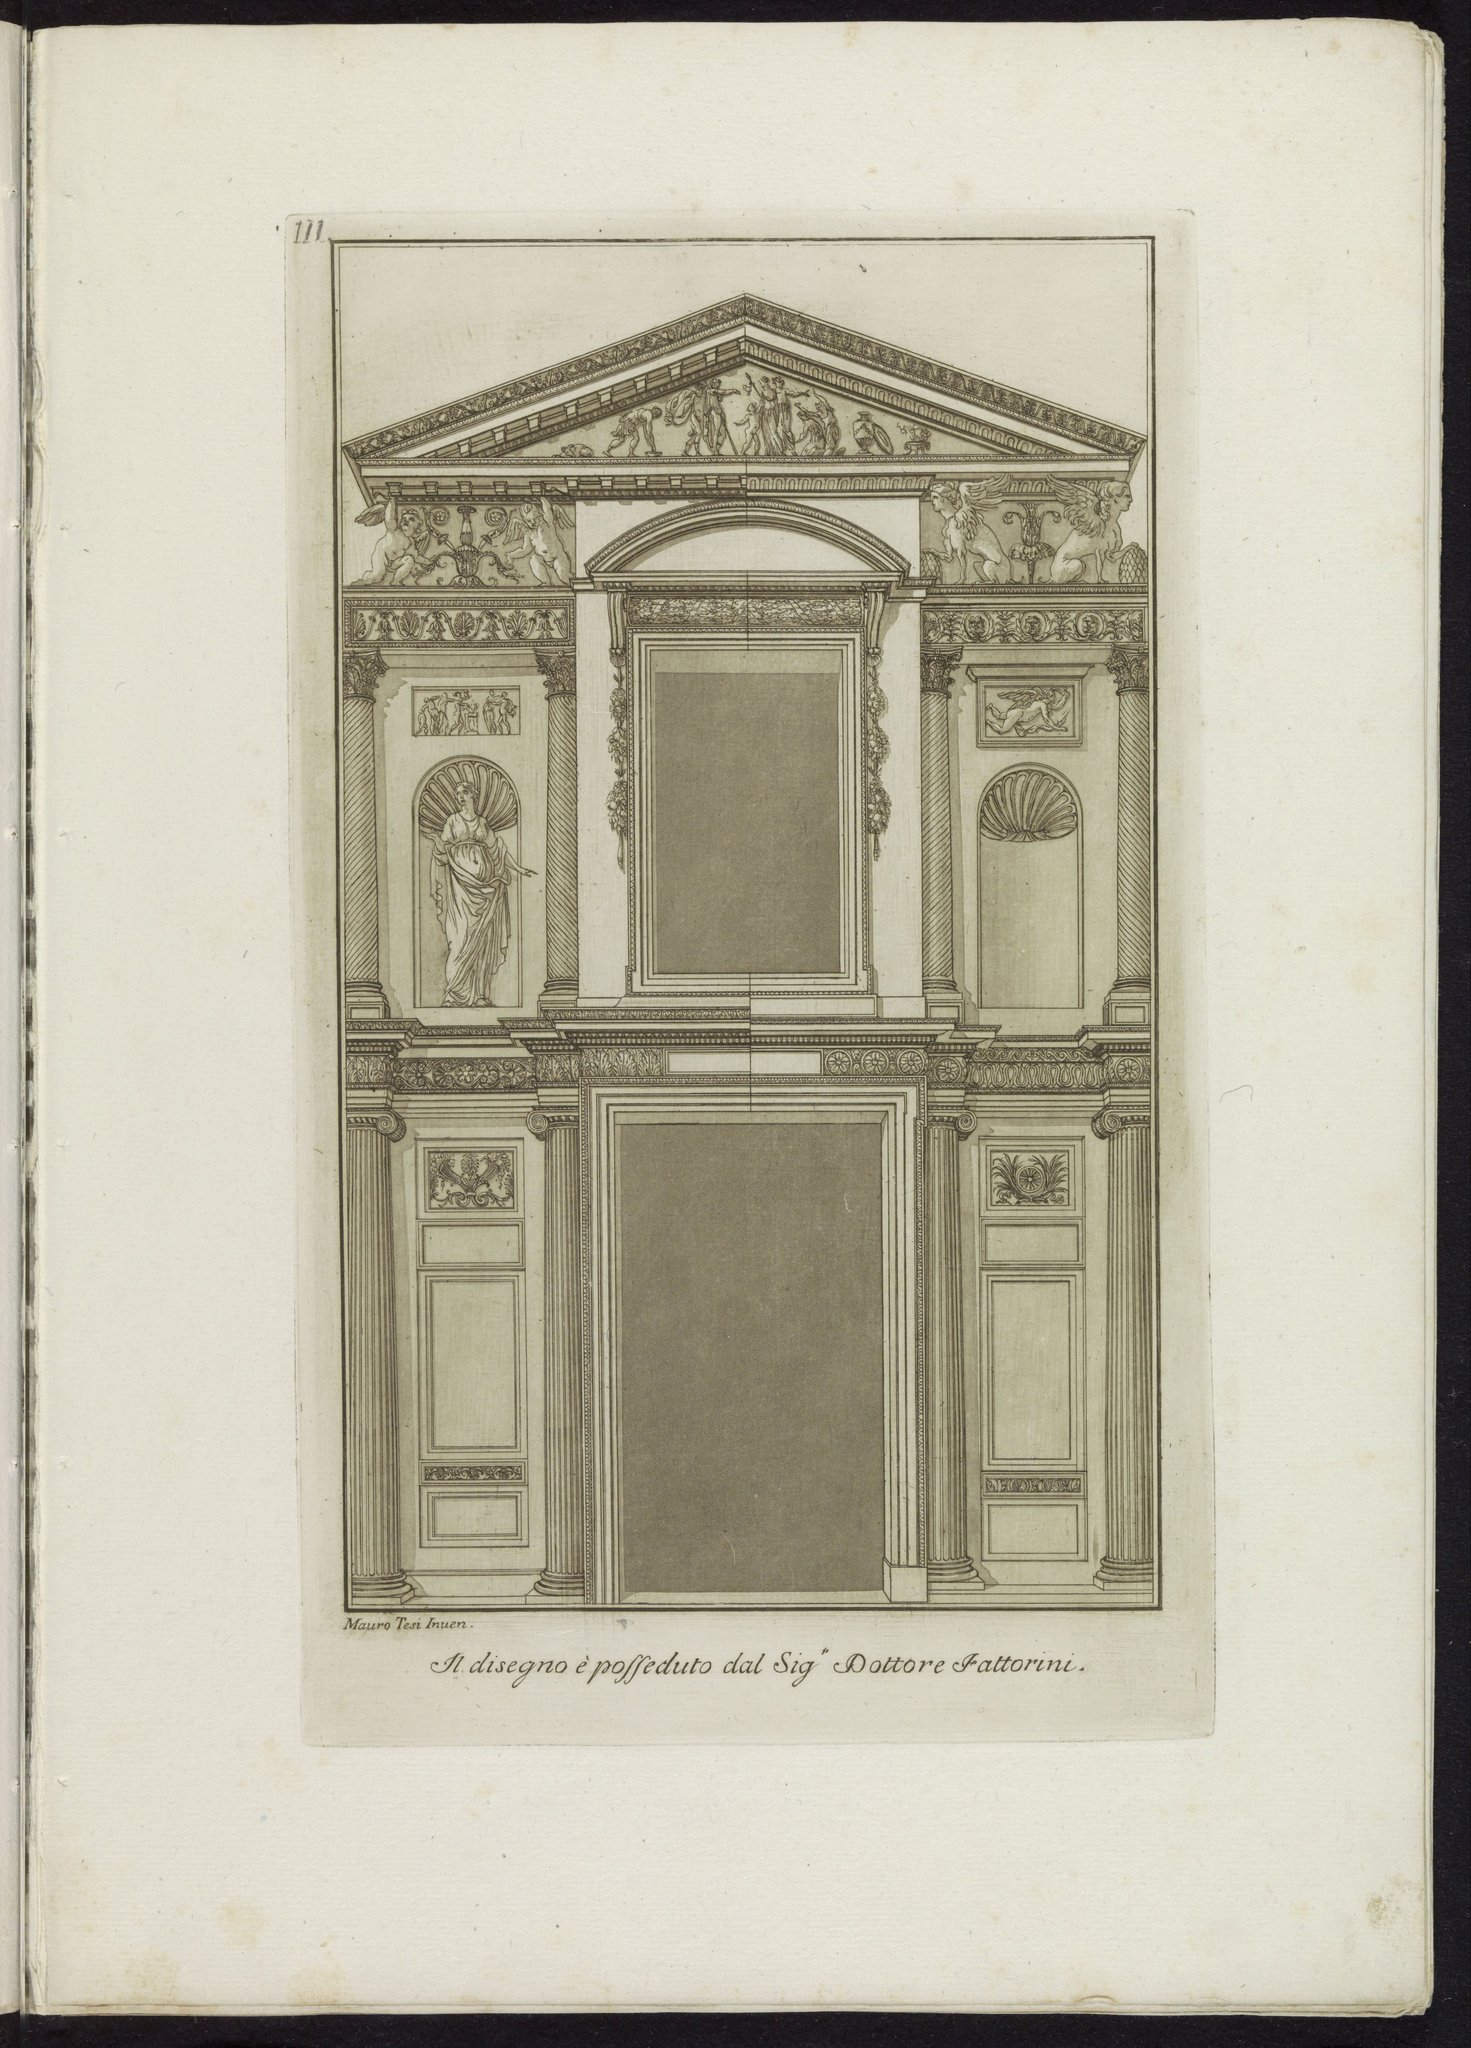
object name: album leaf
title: Raccolta di dissegni originali di Mauro Tesi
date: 1787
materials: paper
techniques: aquatint, etching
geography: bologna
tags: parts of church exterior and annexes: portal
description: Ontwerp voor een portaal, in een nis linksbovenin staat een sculptuur van een vrouw. Prent maakt deel uit van een album.